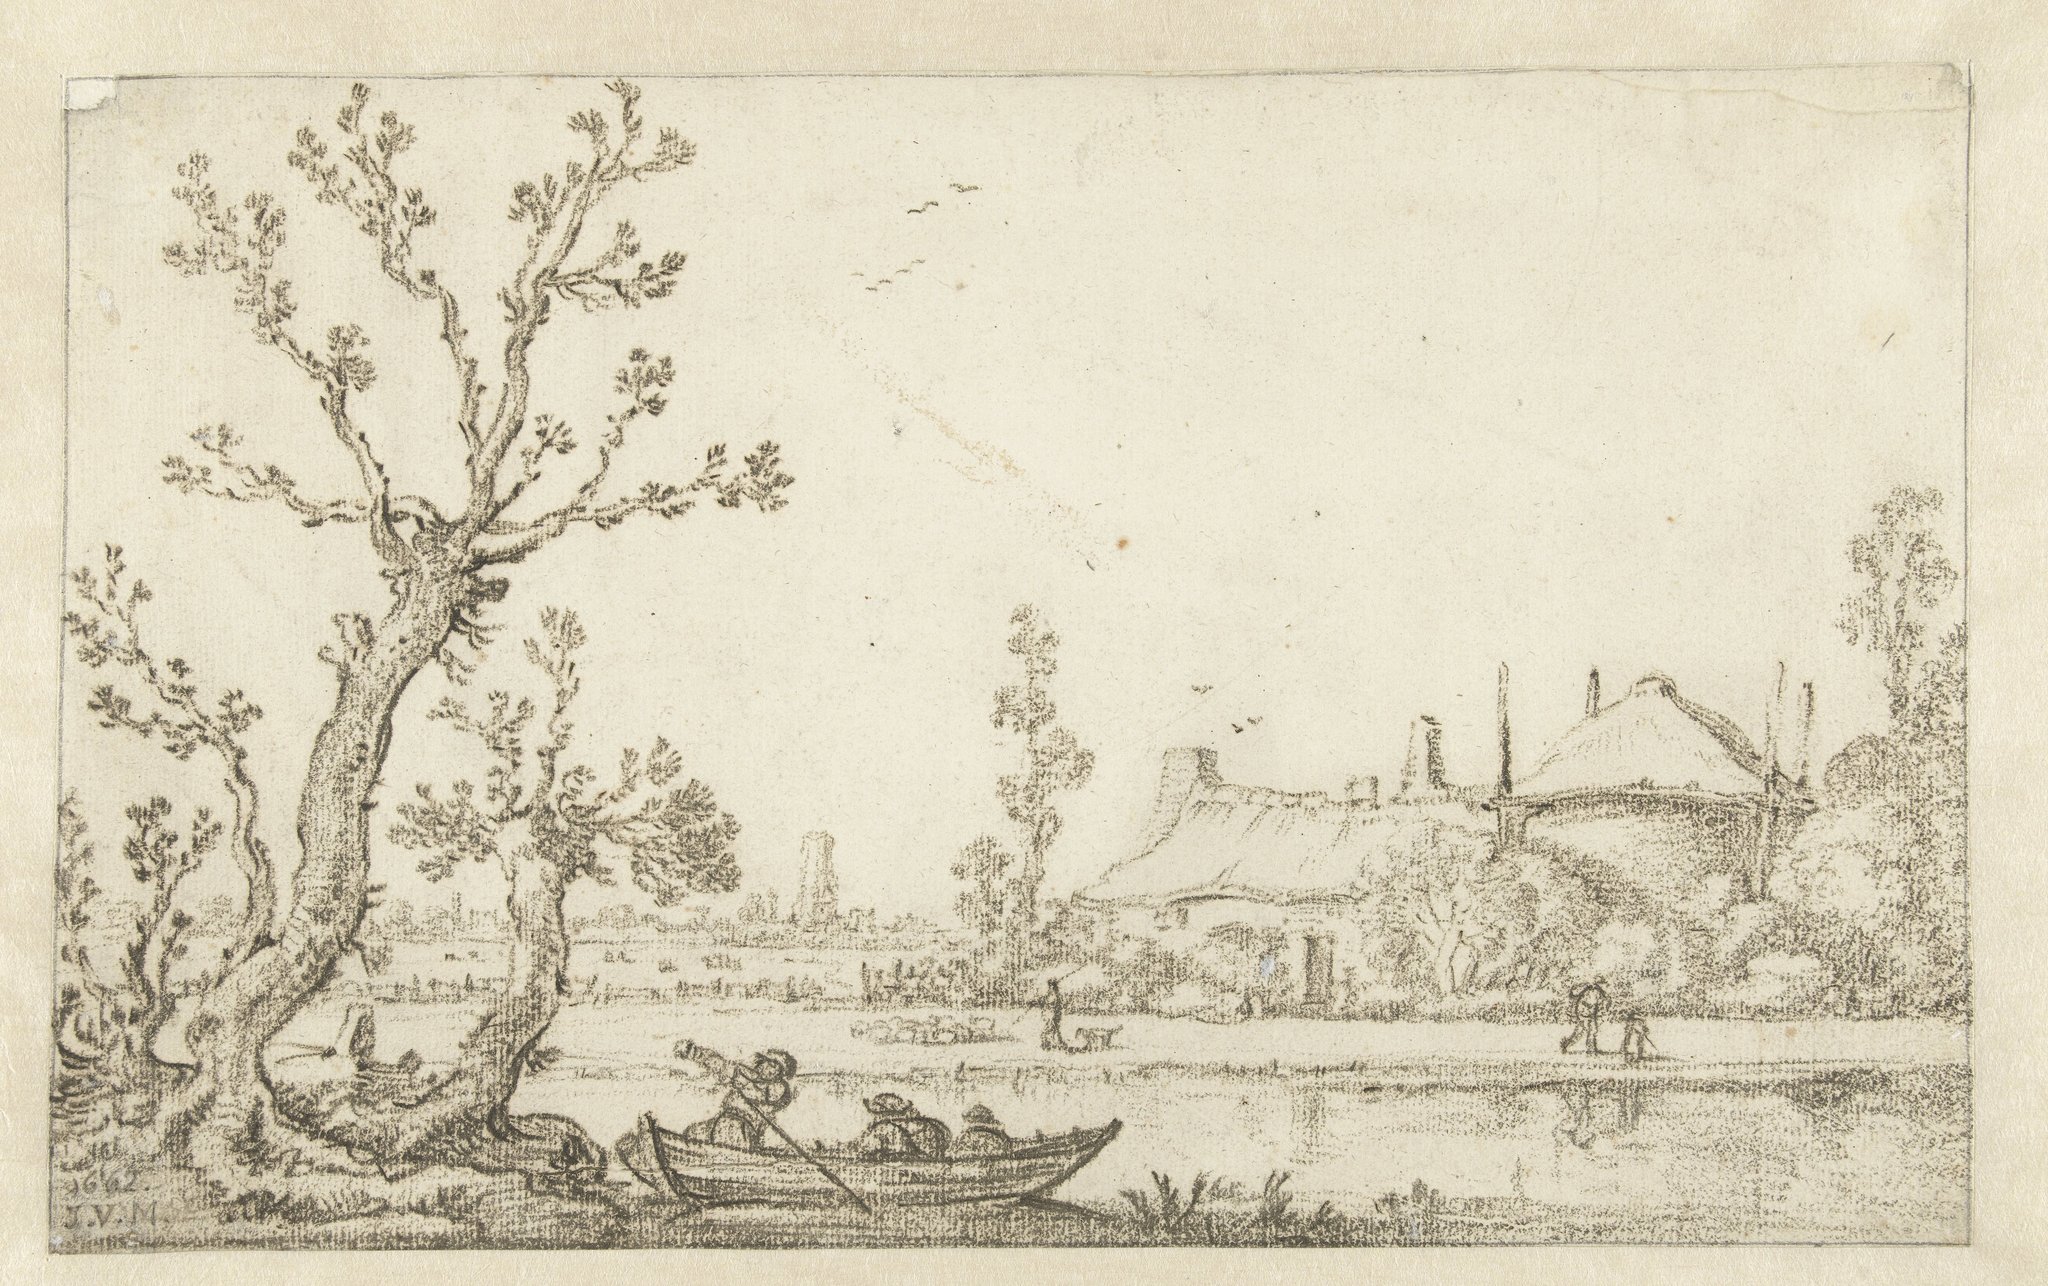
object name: drawing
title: De Boerderij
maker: monogrammist jvm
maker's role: draughtsman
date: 1662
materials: charcoal, paper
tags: river, farm or solitary house in landscape, farm (building)